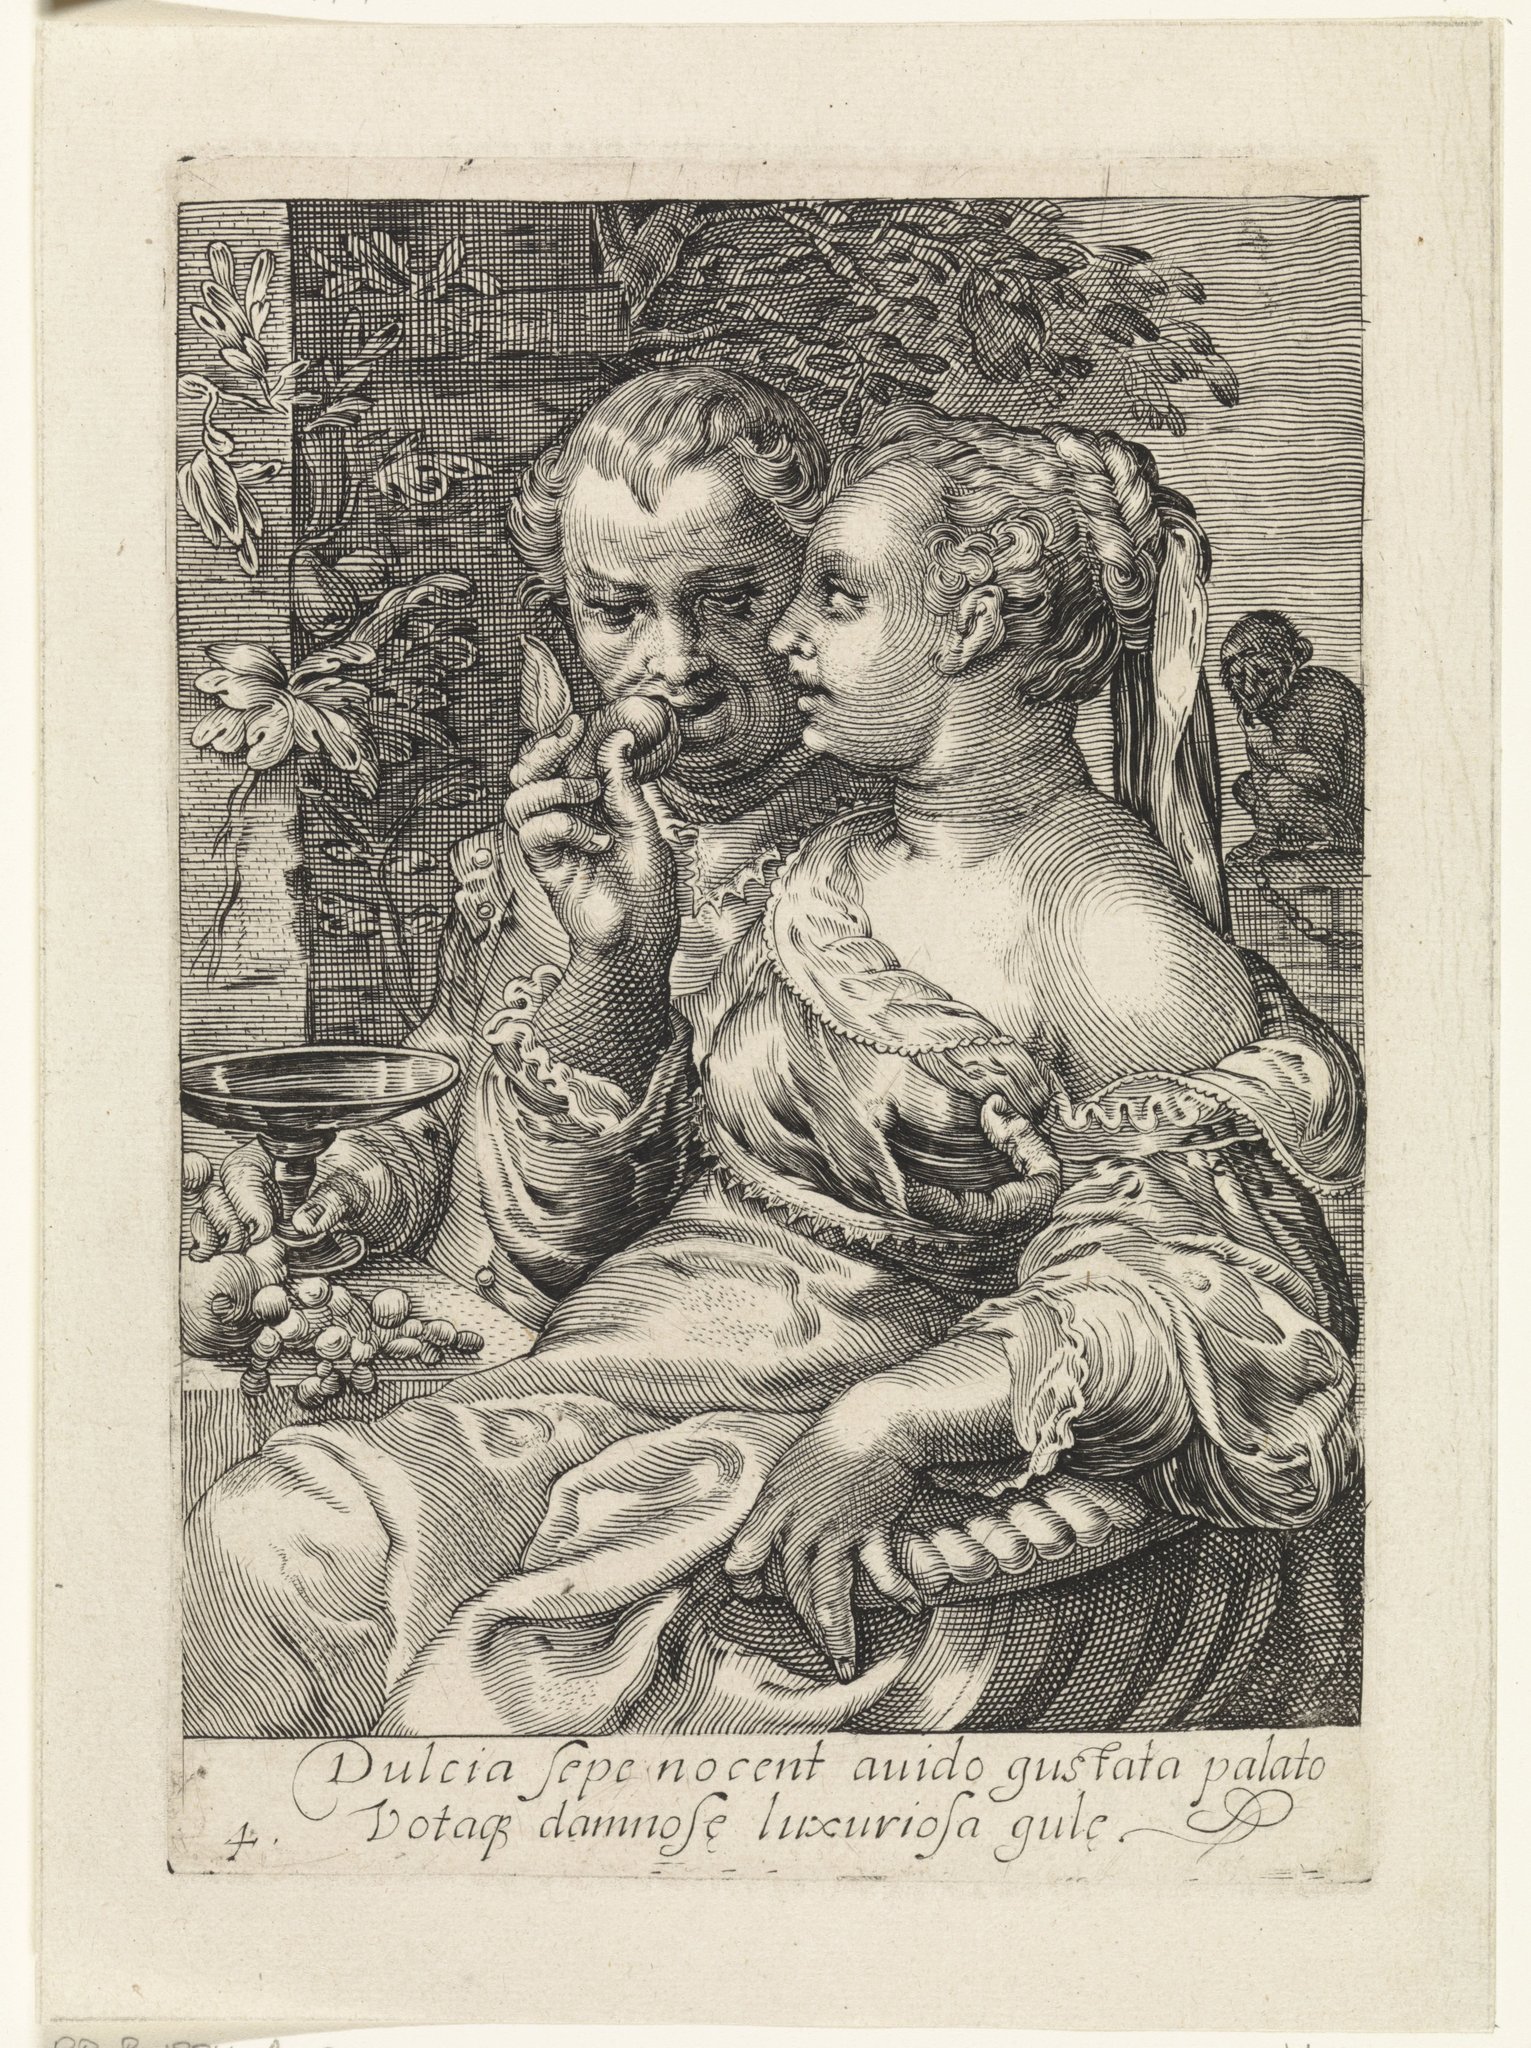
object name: print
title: De Smaak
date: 1575-1657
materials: paper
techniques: engraving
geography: northern netherlands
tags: taste, tasting (one of the five senses), fruits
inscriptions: collector's mark: Lugt 2228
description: De vrouwelijke personificatie van de Smaak laat de man die haar vergezelt een stuk fruit proeven. Bij haar schoot de kop van een hond.